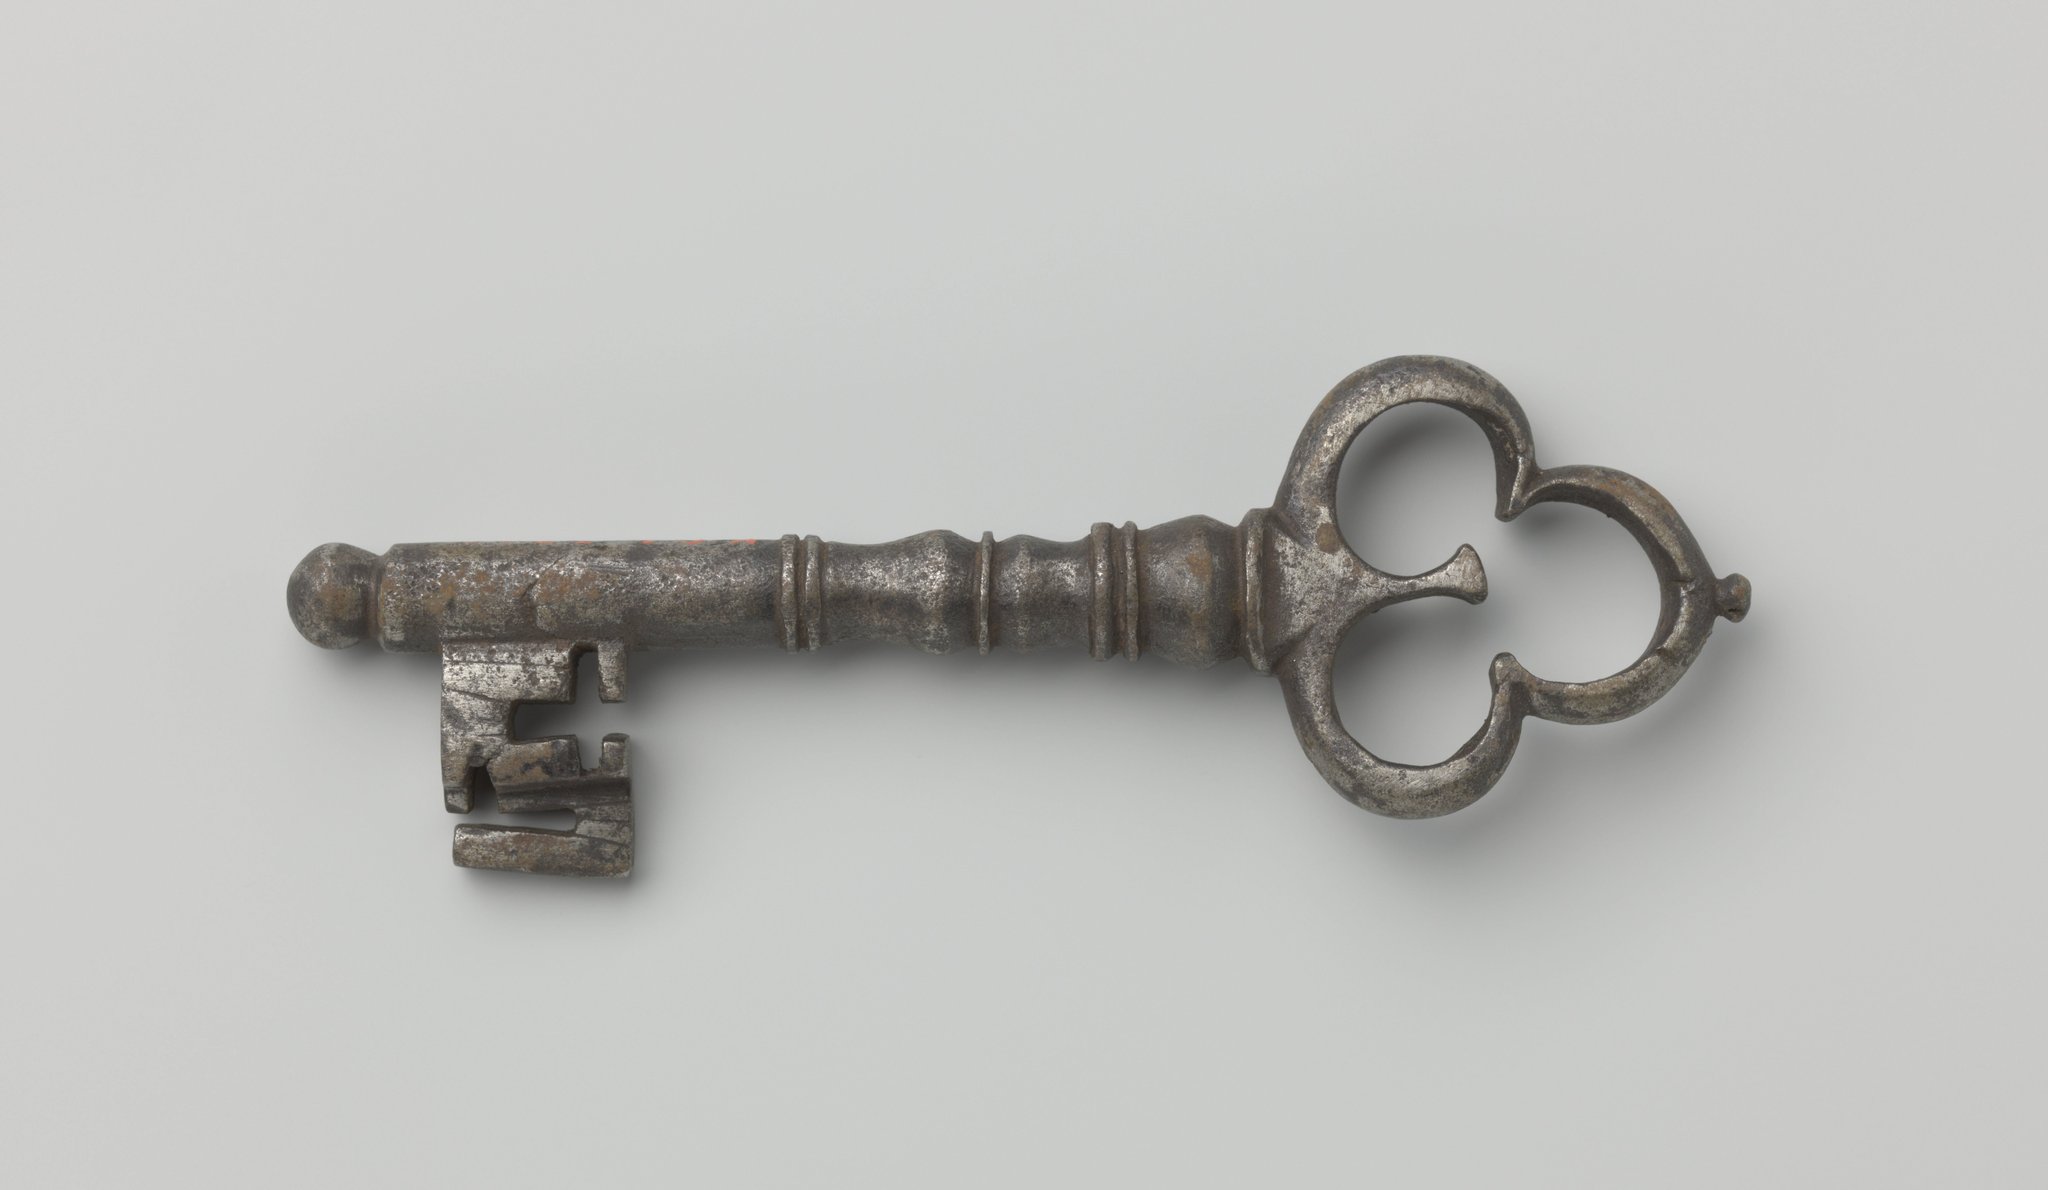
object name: key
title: Sleutel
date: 1500-1600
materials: iron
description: Sleutel met driepasvormig oog, bekroond door een knopje. De schacht is balustervormig en eindigt in een knop.